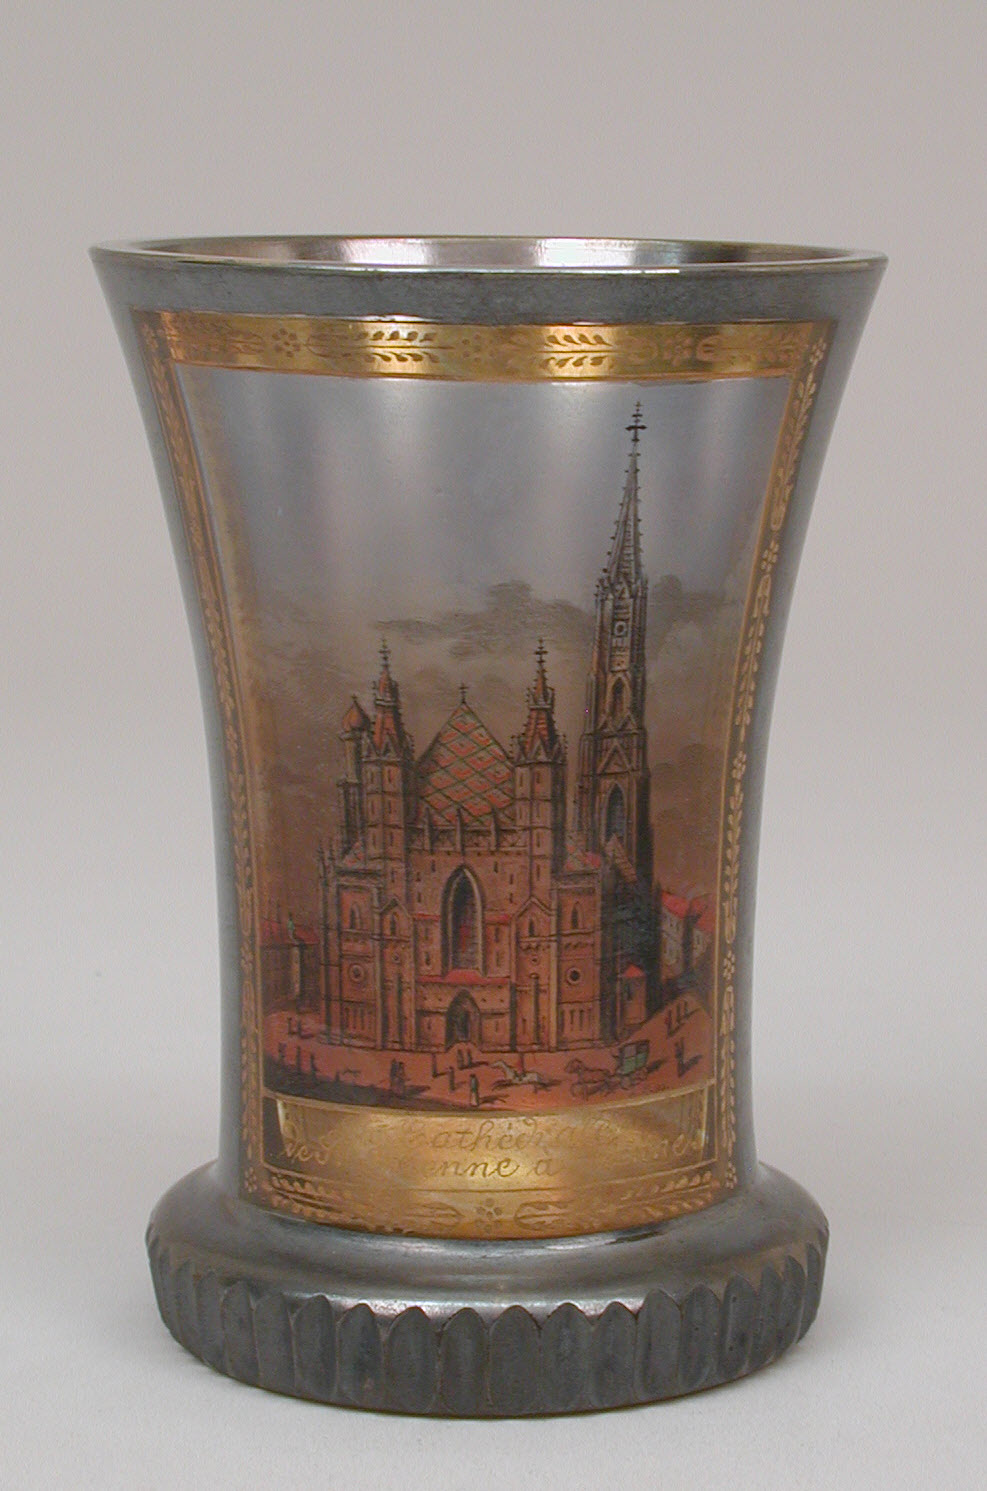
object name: beaker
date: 1820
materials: glass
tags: cathedrals